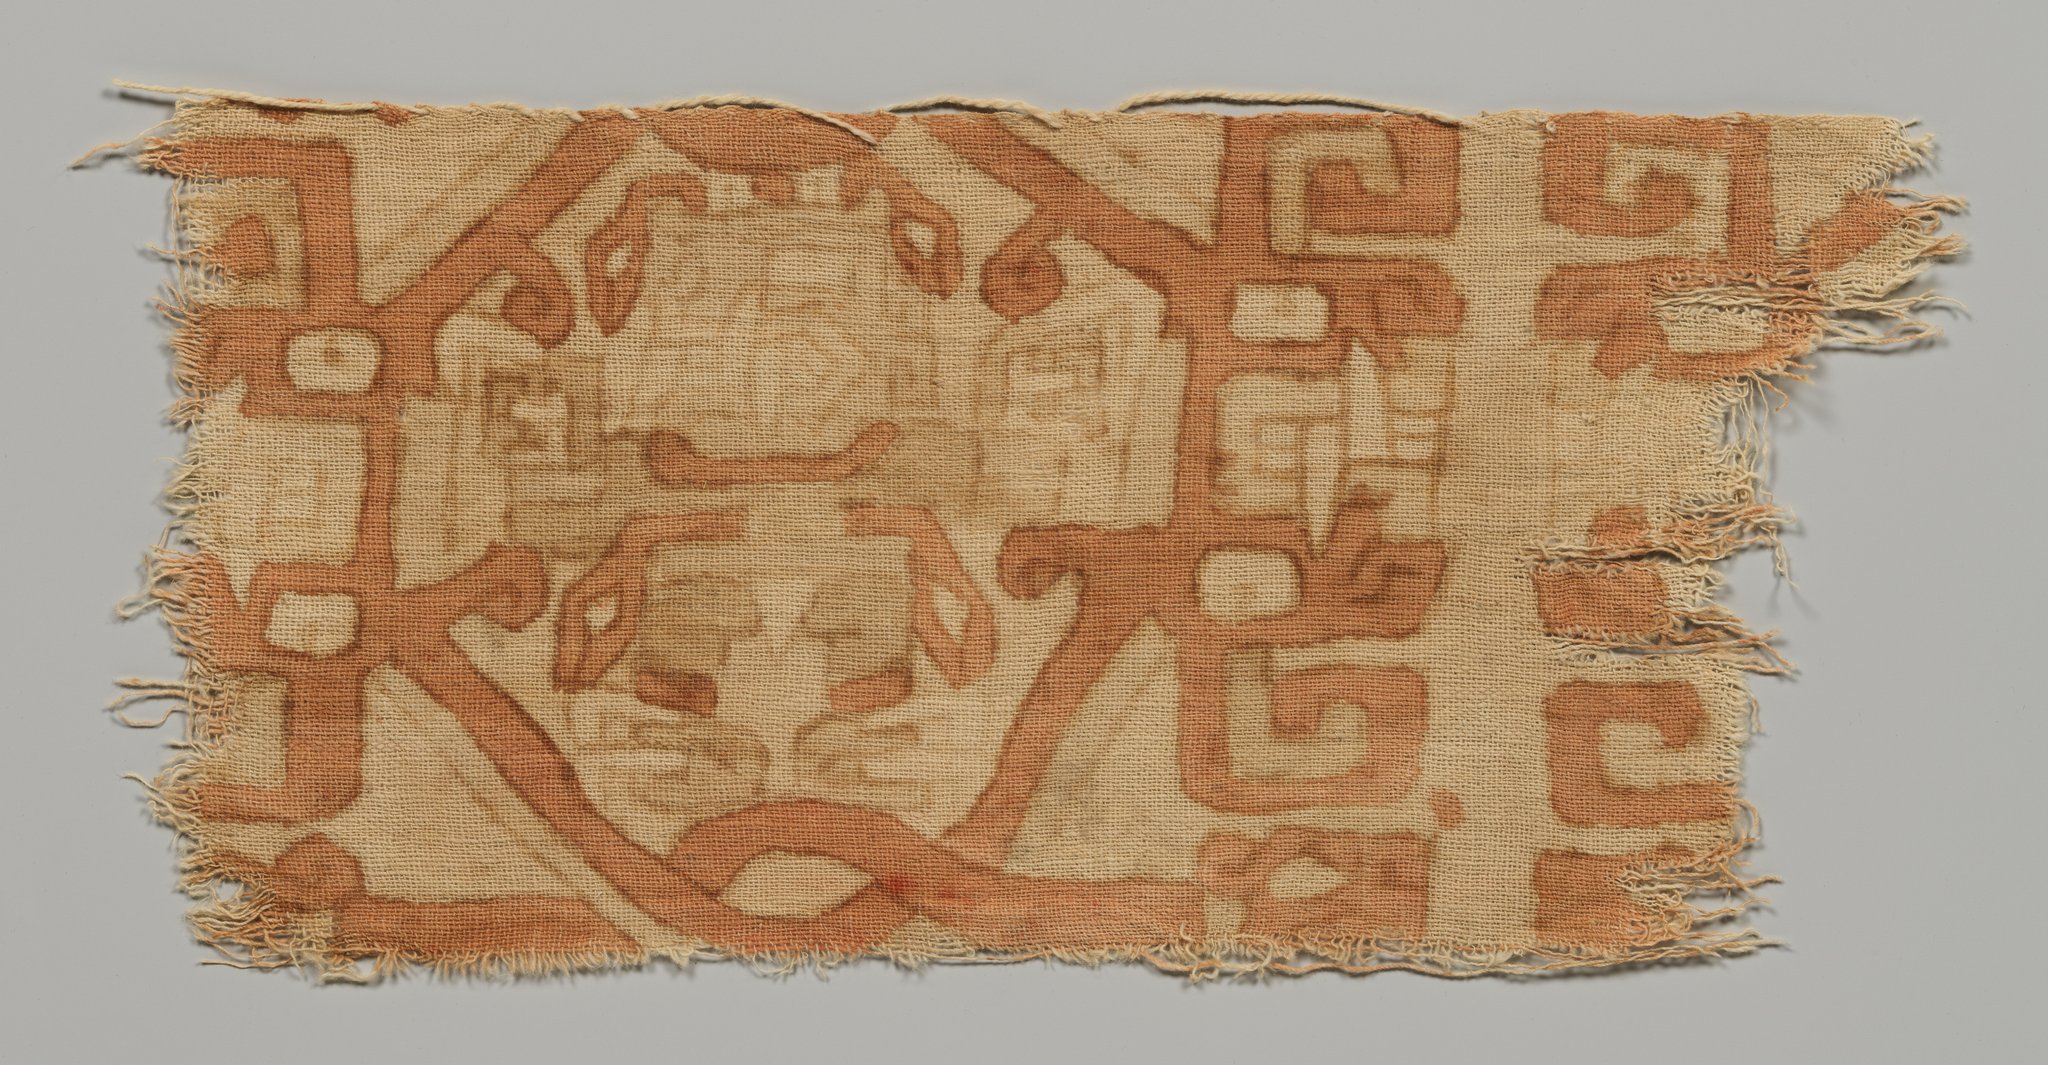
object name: textile fragment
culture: chavin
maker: chavín artist(s)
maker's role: artist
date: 400-201 BCE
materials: cotton, iron, pigment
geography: peru